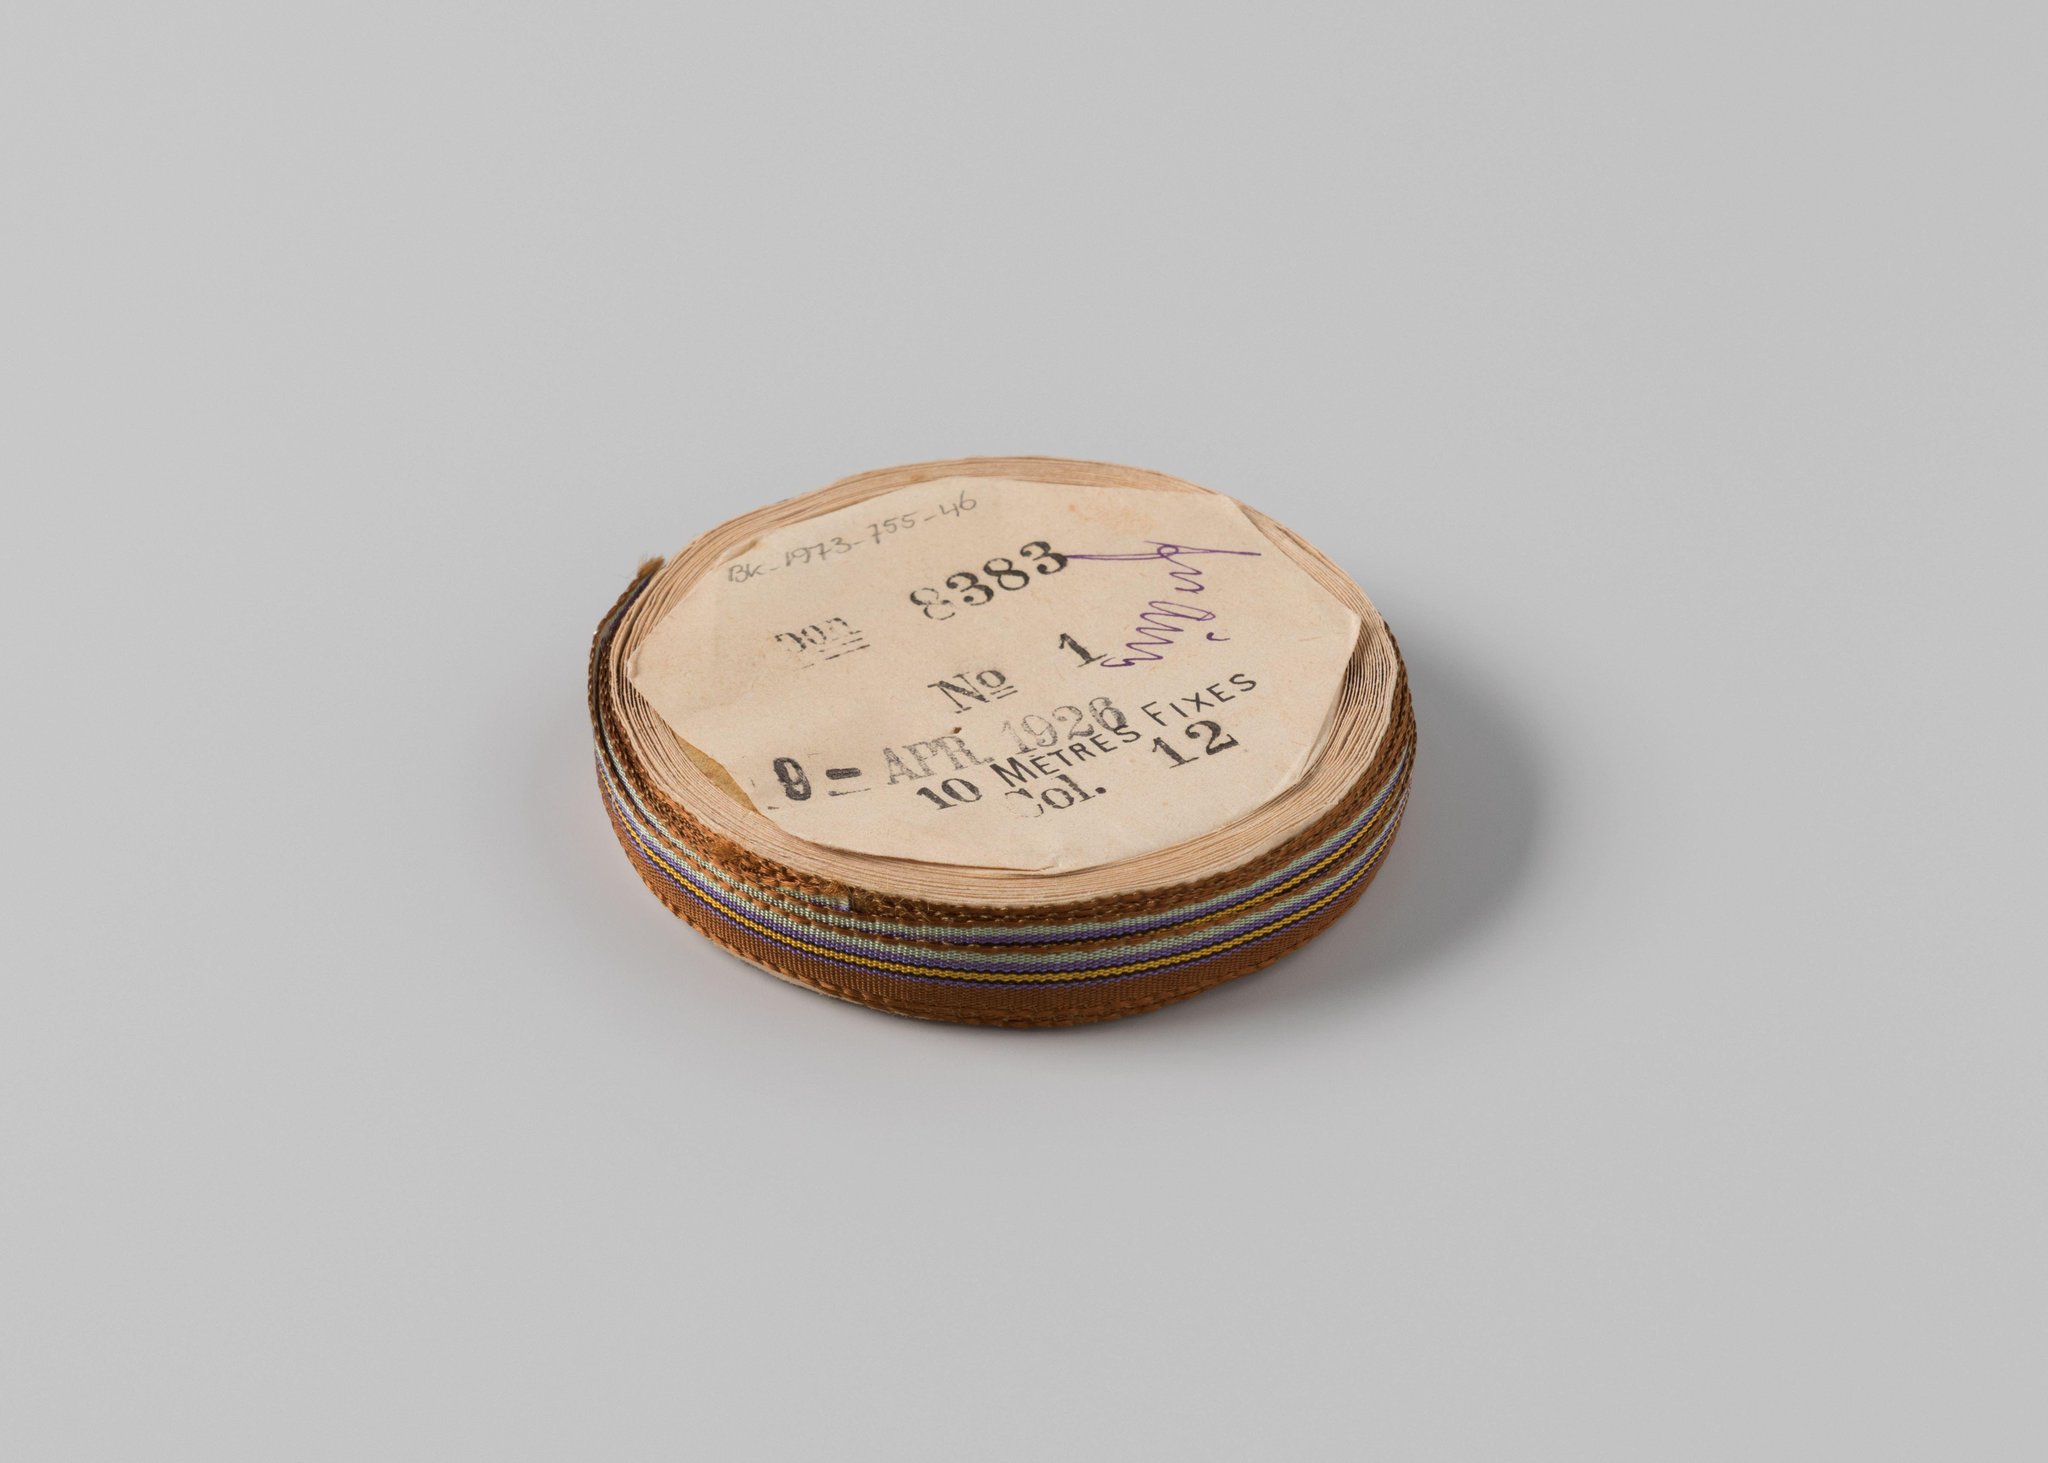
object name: ribbon material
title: Lint op rol, gestreept, bruin met lila, zwart, lichtgroen en oranje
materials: cardboard, paper, textile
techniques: weave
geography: nijmegen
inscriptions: stamp: ‘9 - APR. 1926’, number: ‘Pon 8383’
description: Lint op rol, gestreept, bruin met lila, zwart, lichtgroen en oranje.